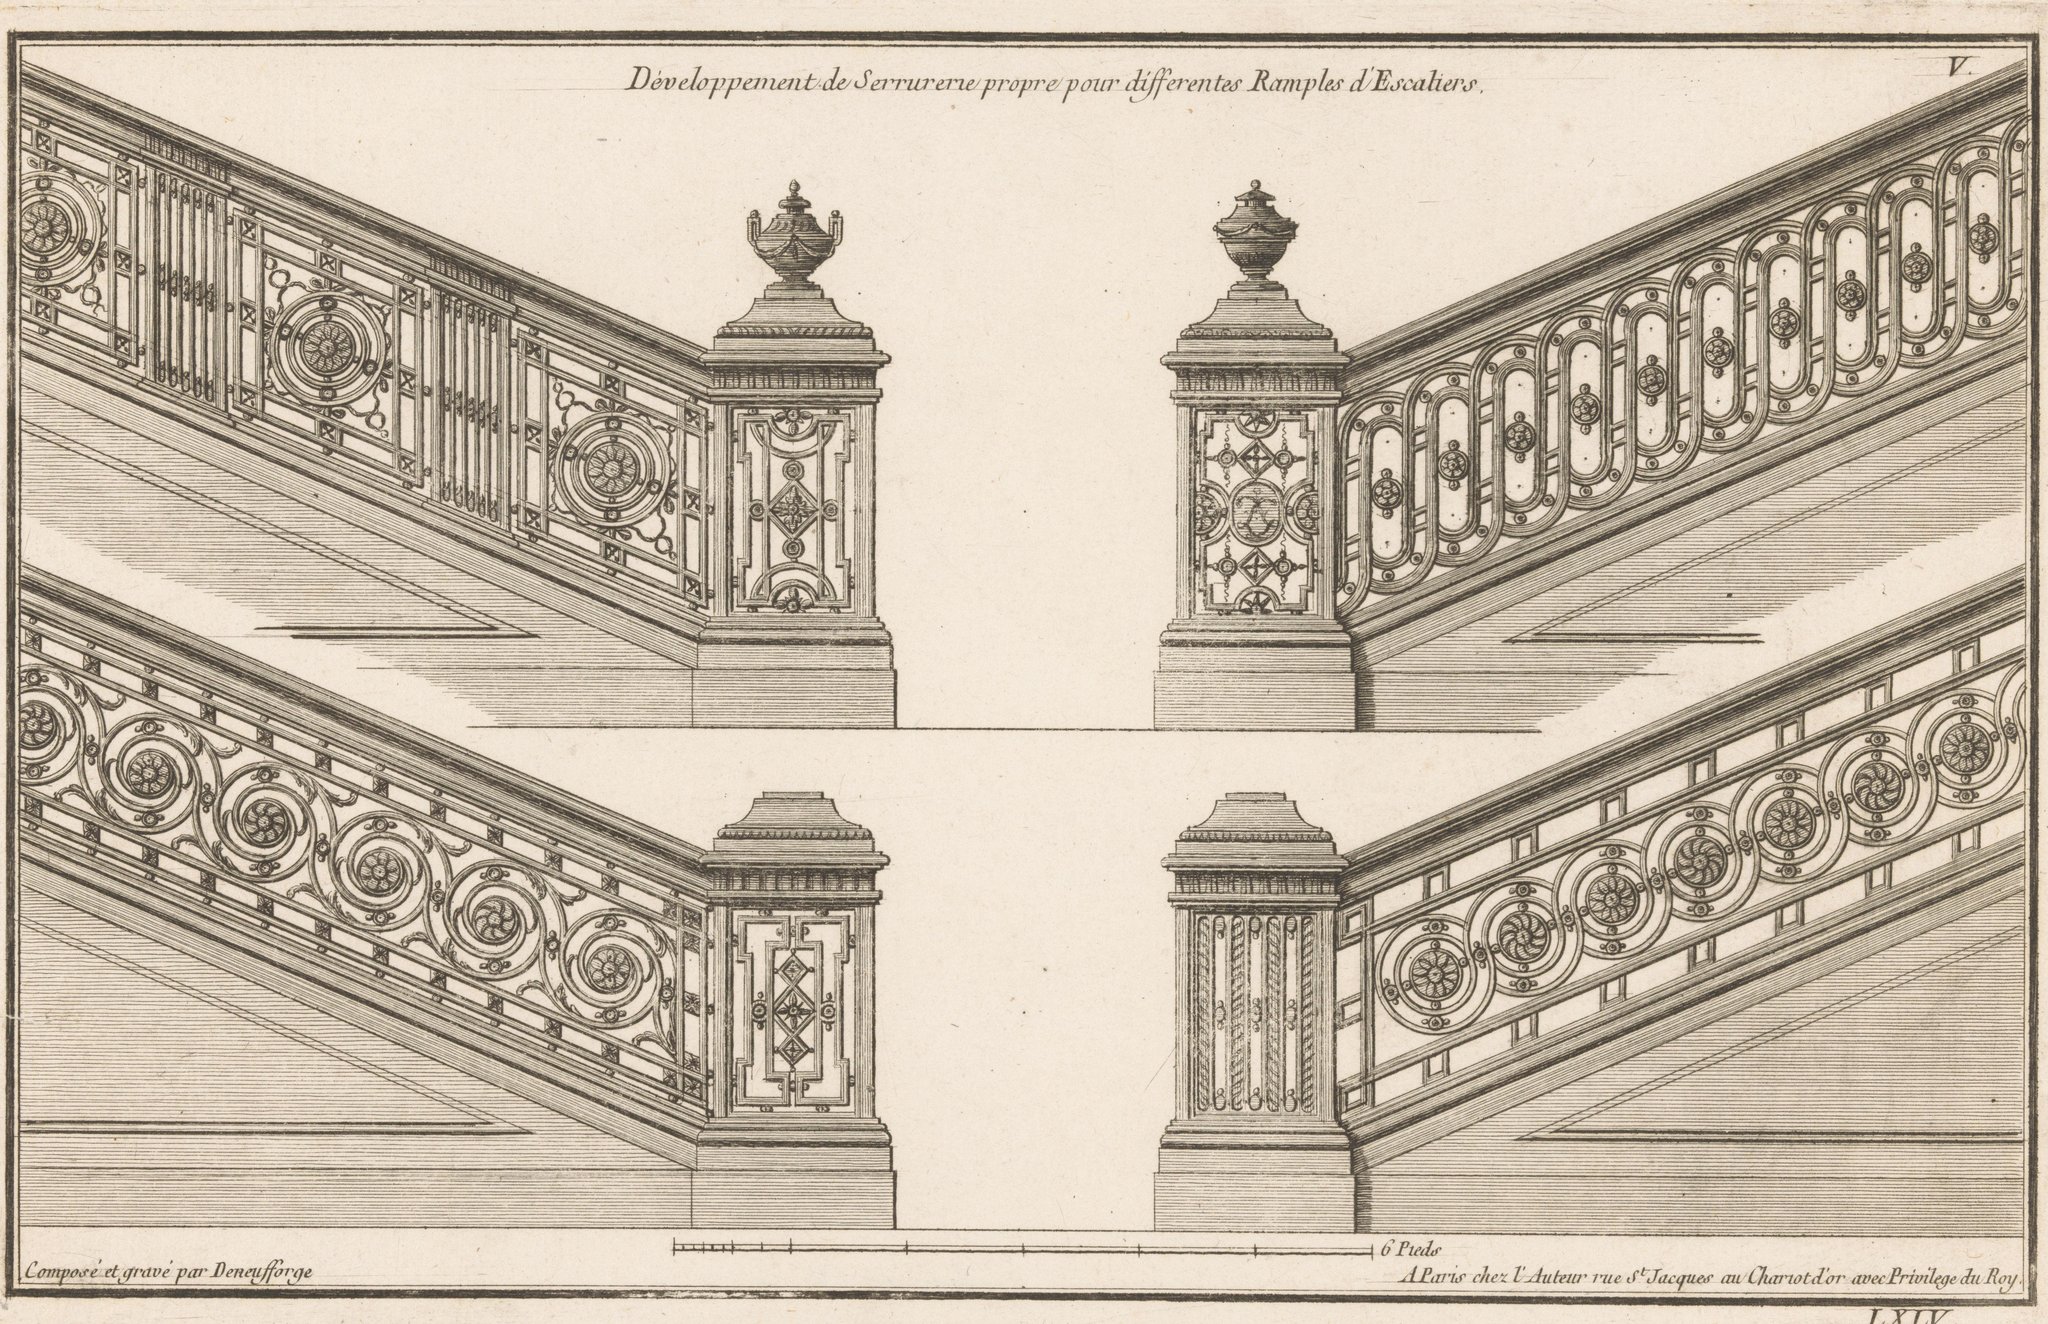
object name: print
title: XVIe Cahier du Supplement Suite de la Serrurerie contenant des Portes et fermetures propre à l'usage des Choeurs d'Eglise et autres Edifices publics et particuliers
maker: jean françois de neufforge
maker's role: print maker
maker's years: 1714-1791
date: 1772-1780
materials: paper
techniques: etching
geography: paris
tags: staircase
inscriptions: collector's mark: Lugt 2760, collector's mark: Lugt 2228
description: Vier smeedijzeren traphekken met bloemmotieven. Prentnummer LXLV.